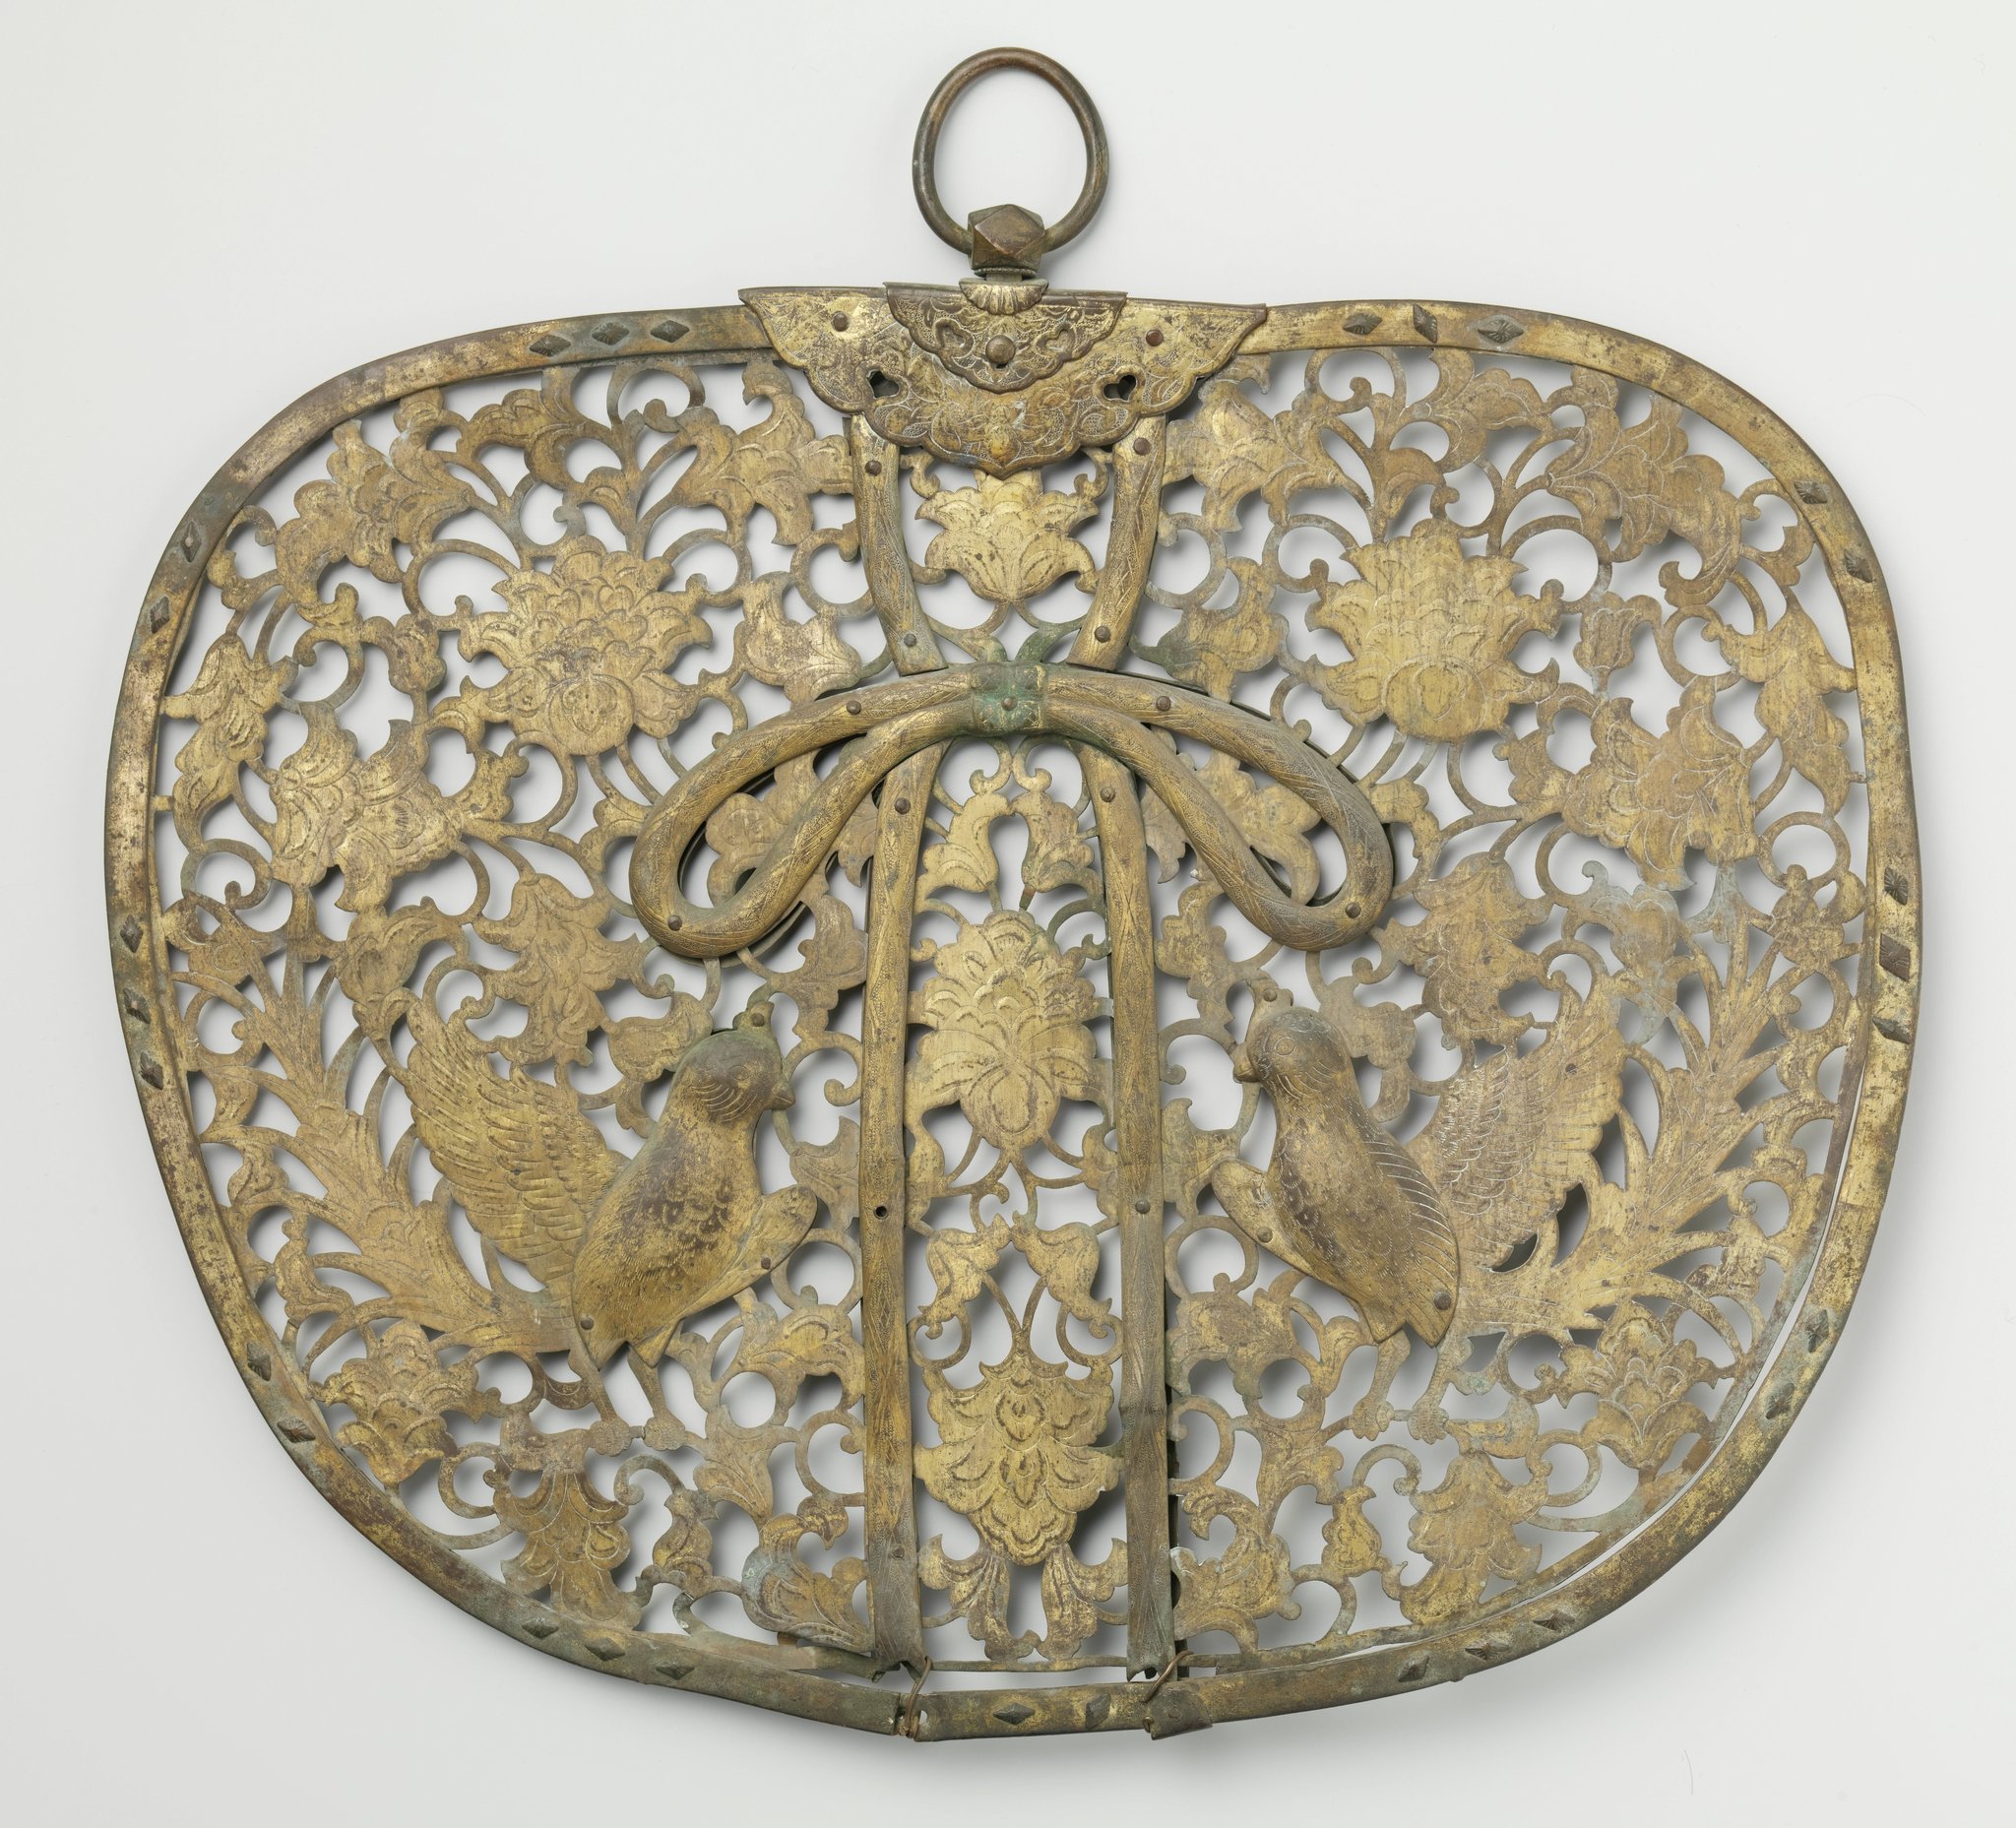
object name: altaarhanger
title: Altar pendant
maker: Anonymous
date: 1200-1300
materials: bronze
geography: japan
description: Fan-shaped ornaments form part of the array of Buddhist sculpture in a temple, where they hang above and around the figures. They developed from flower decorations, bound with ribbons, which served as offerings in earlier times. Despite the fact that this metal ornament could not have been viewed from close at hand, it is executed in great detail, with precise openwork motifs of flowers and birds.